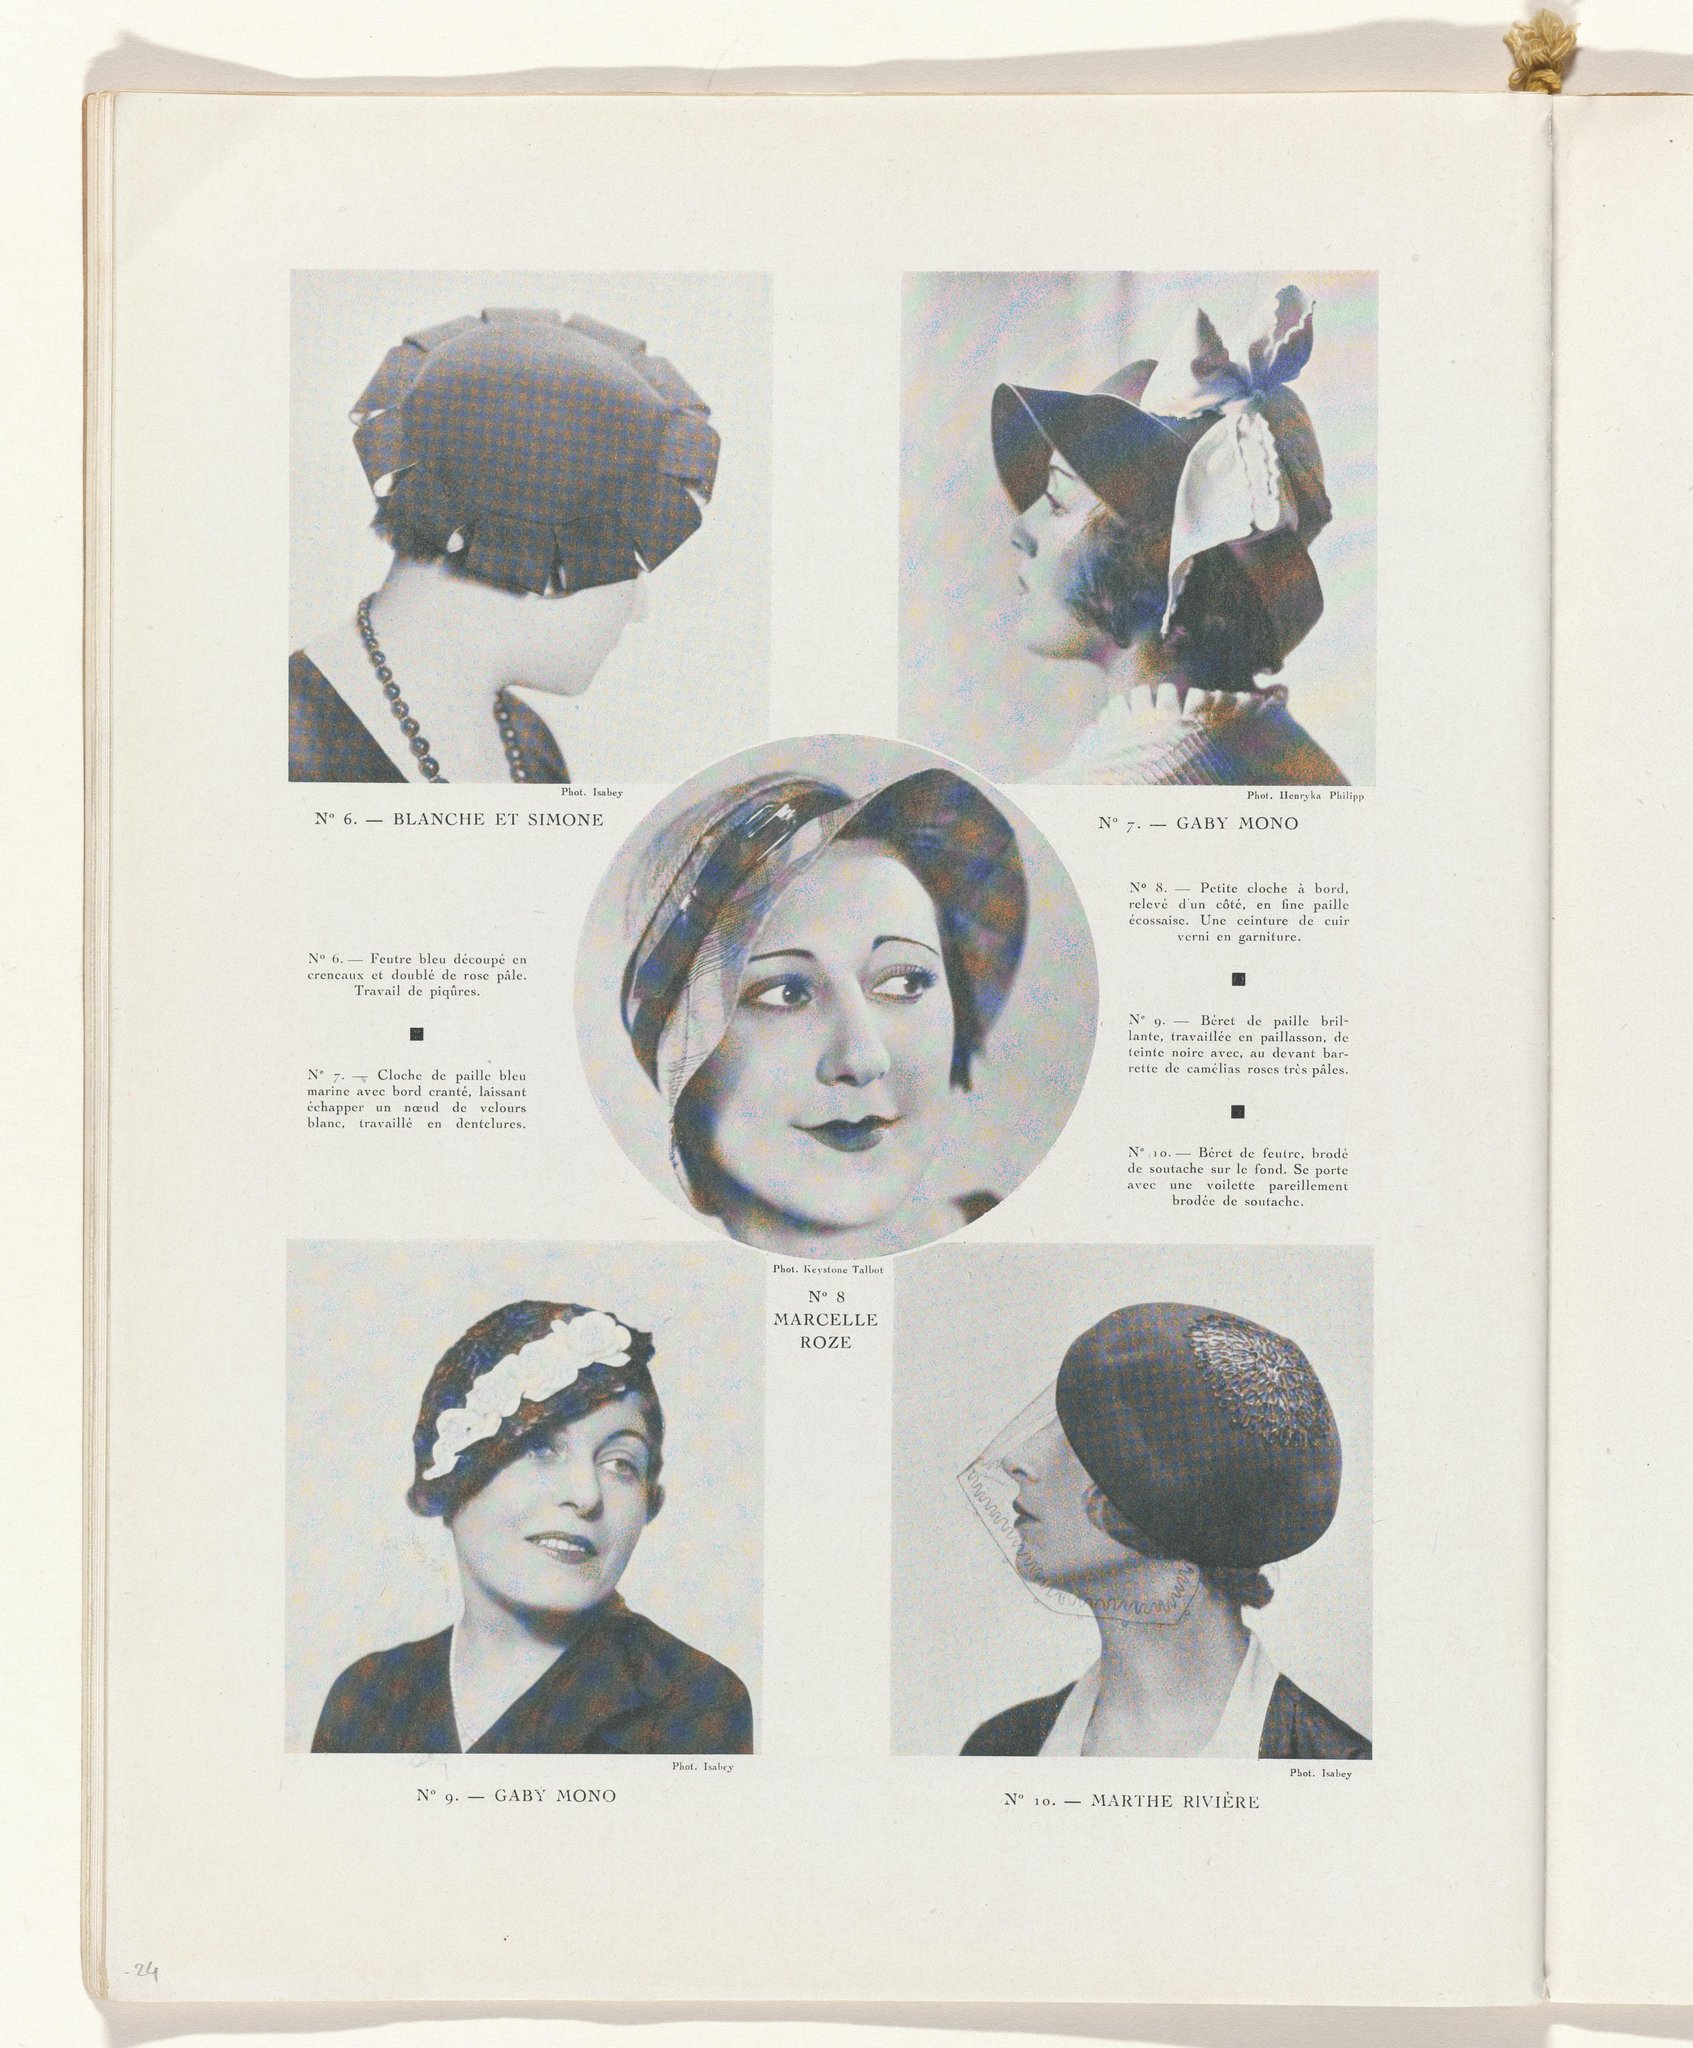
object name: magazine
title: Art - Goût - Beauté, Feuillets de l' élégance féminine, Mars 1932, No. 139, 12e Année, p. 24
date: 1932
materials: paper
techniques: photography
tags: veil (+ women's clothes), head-gear: beret (+ women's clothes), fashion plates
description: Vijf vrouwenhoofden met verschillende cloches (pothoeden) en baretten van Blanche et Simone, Gaby Mono, Marcelle Roze en Marthe Rivière, genummerd 6 tot en met 10. Pagina uit het modetijdschrift Art-Goût-Beauté (1920-1933).